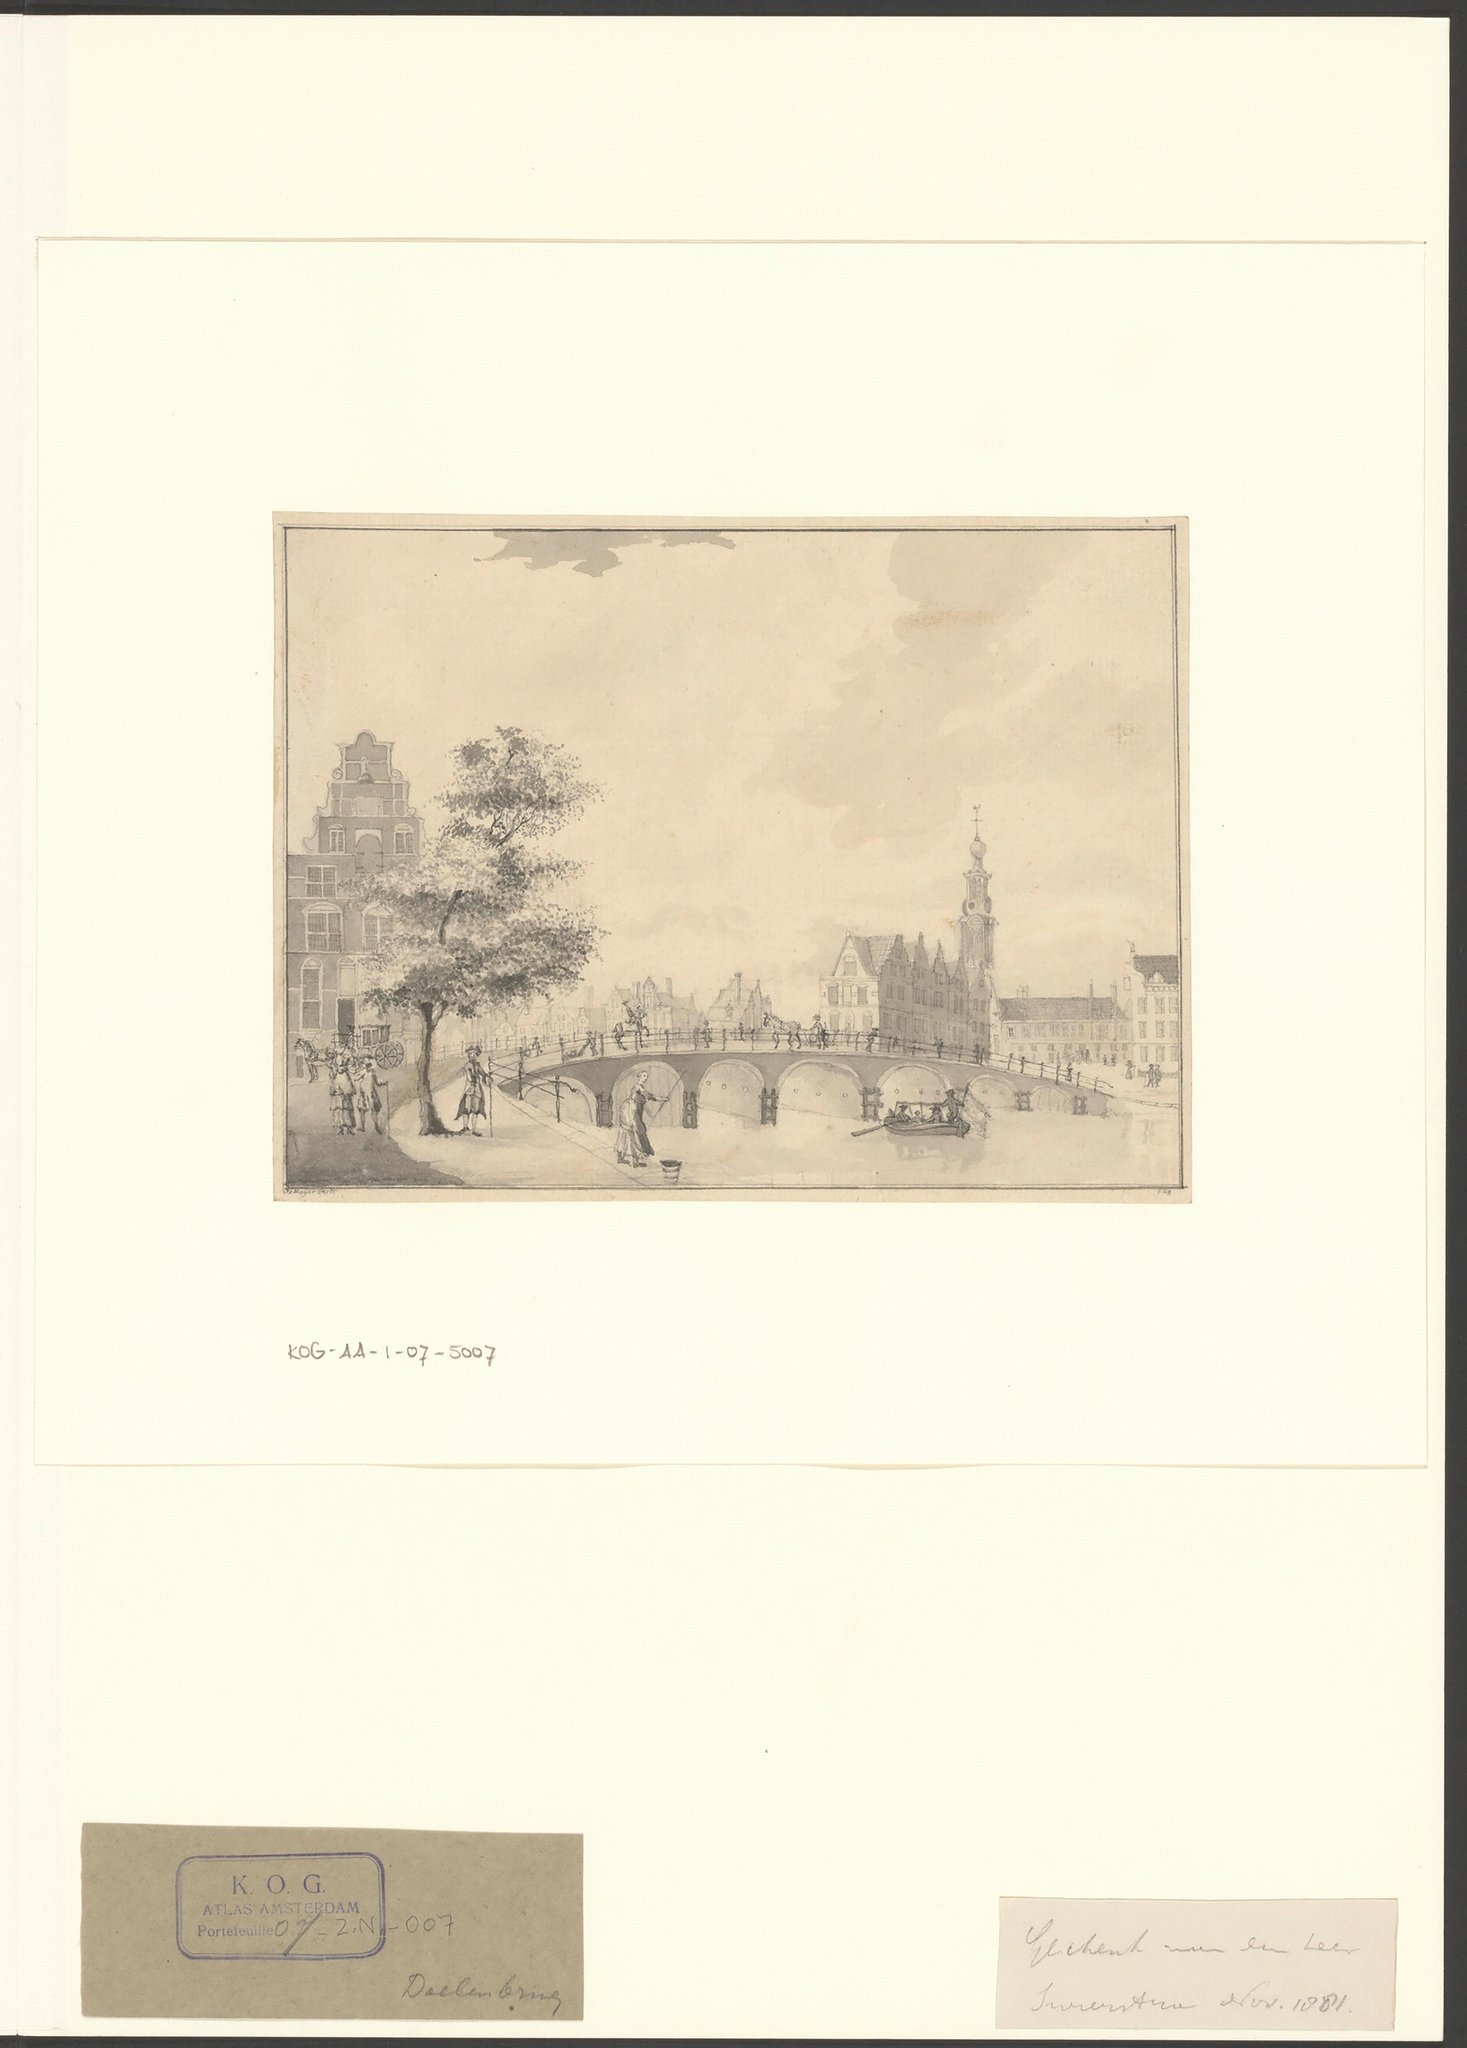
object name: drawing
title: Gezicht op de Doelensluis over de Amstel met zicht op de Munttoren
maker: Anonymous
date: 1750-1799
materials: ink, paper, pencil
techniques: brush, pen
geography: amsterdam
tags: tower, clock tower ~ monumental adornment, city-view in general; 'veduta', river, bridge in city across river, canal, etc., boat propelled by man or animal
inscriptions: collector's mark: ‘07’ Lugt 1641b, inscription: ‘Port. 7’, signature: ‘J.A.Meyer fecit / PG[...]’, inscription: ‘Geschenk van den heer I[...]t[...] Nov. 1881.’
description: Onderwerpsrubriek binnen de Atlas Amsterdam: Damrak, Damstraat, Doelensluis, Doelenstraat (Nieuwe), Driehoekstraat, Droogbak, Duvelshoek, Dijkstraat en Korte -.